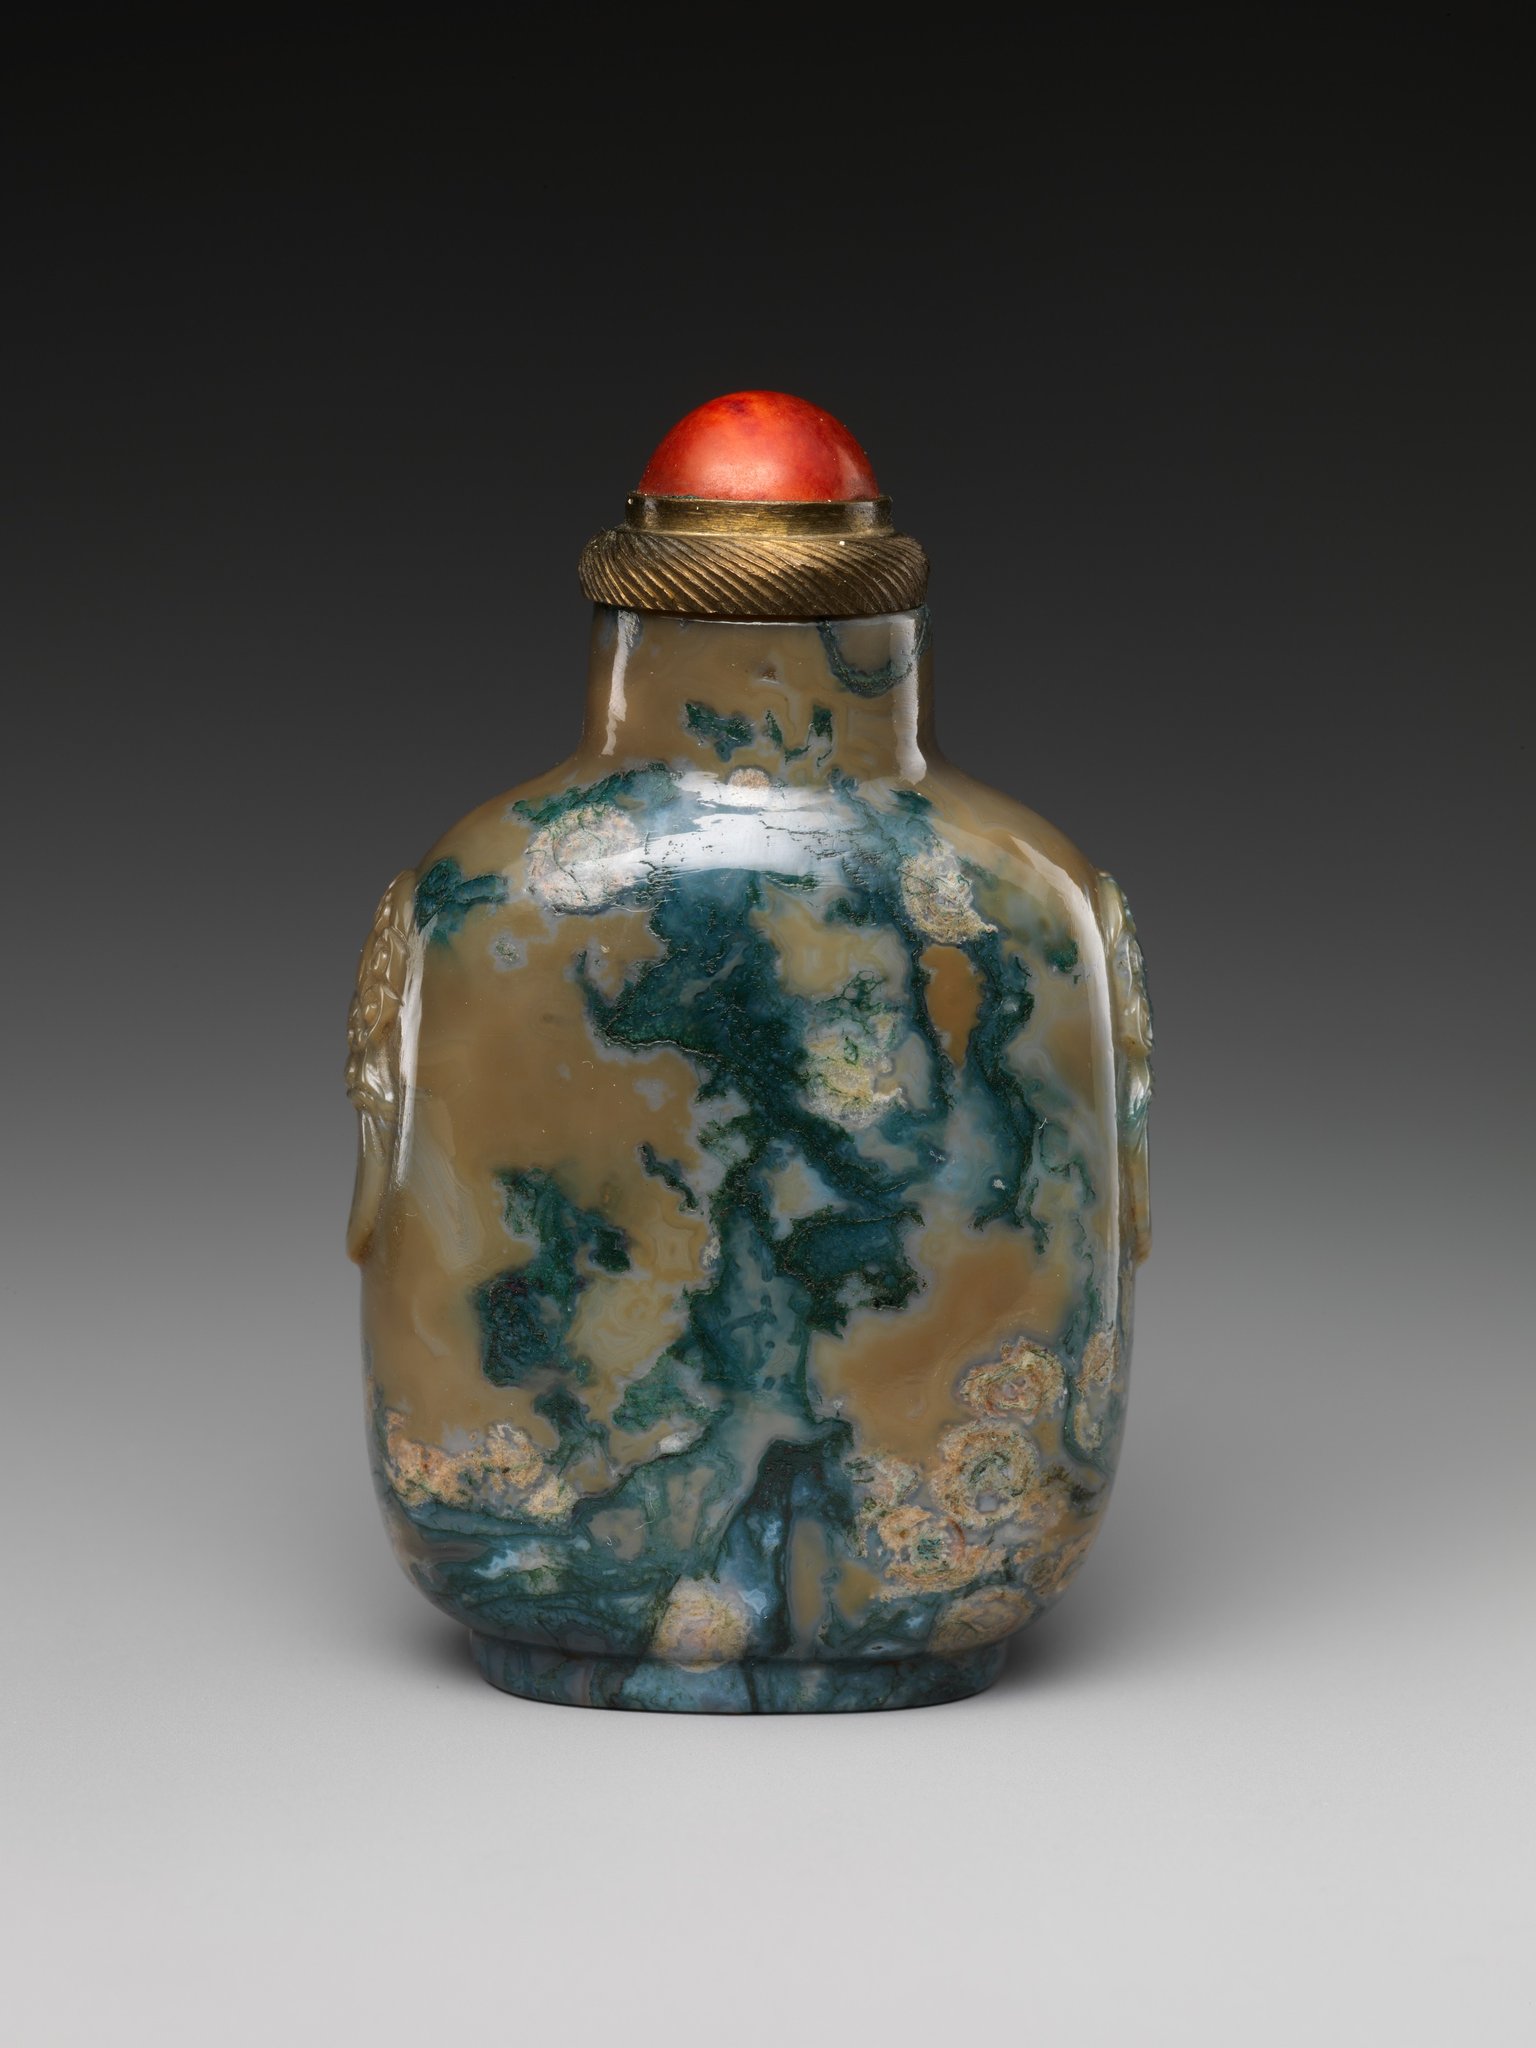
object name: snuff bottle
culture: chinese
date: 1801-1900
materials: stone